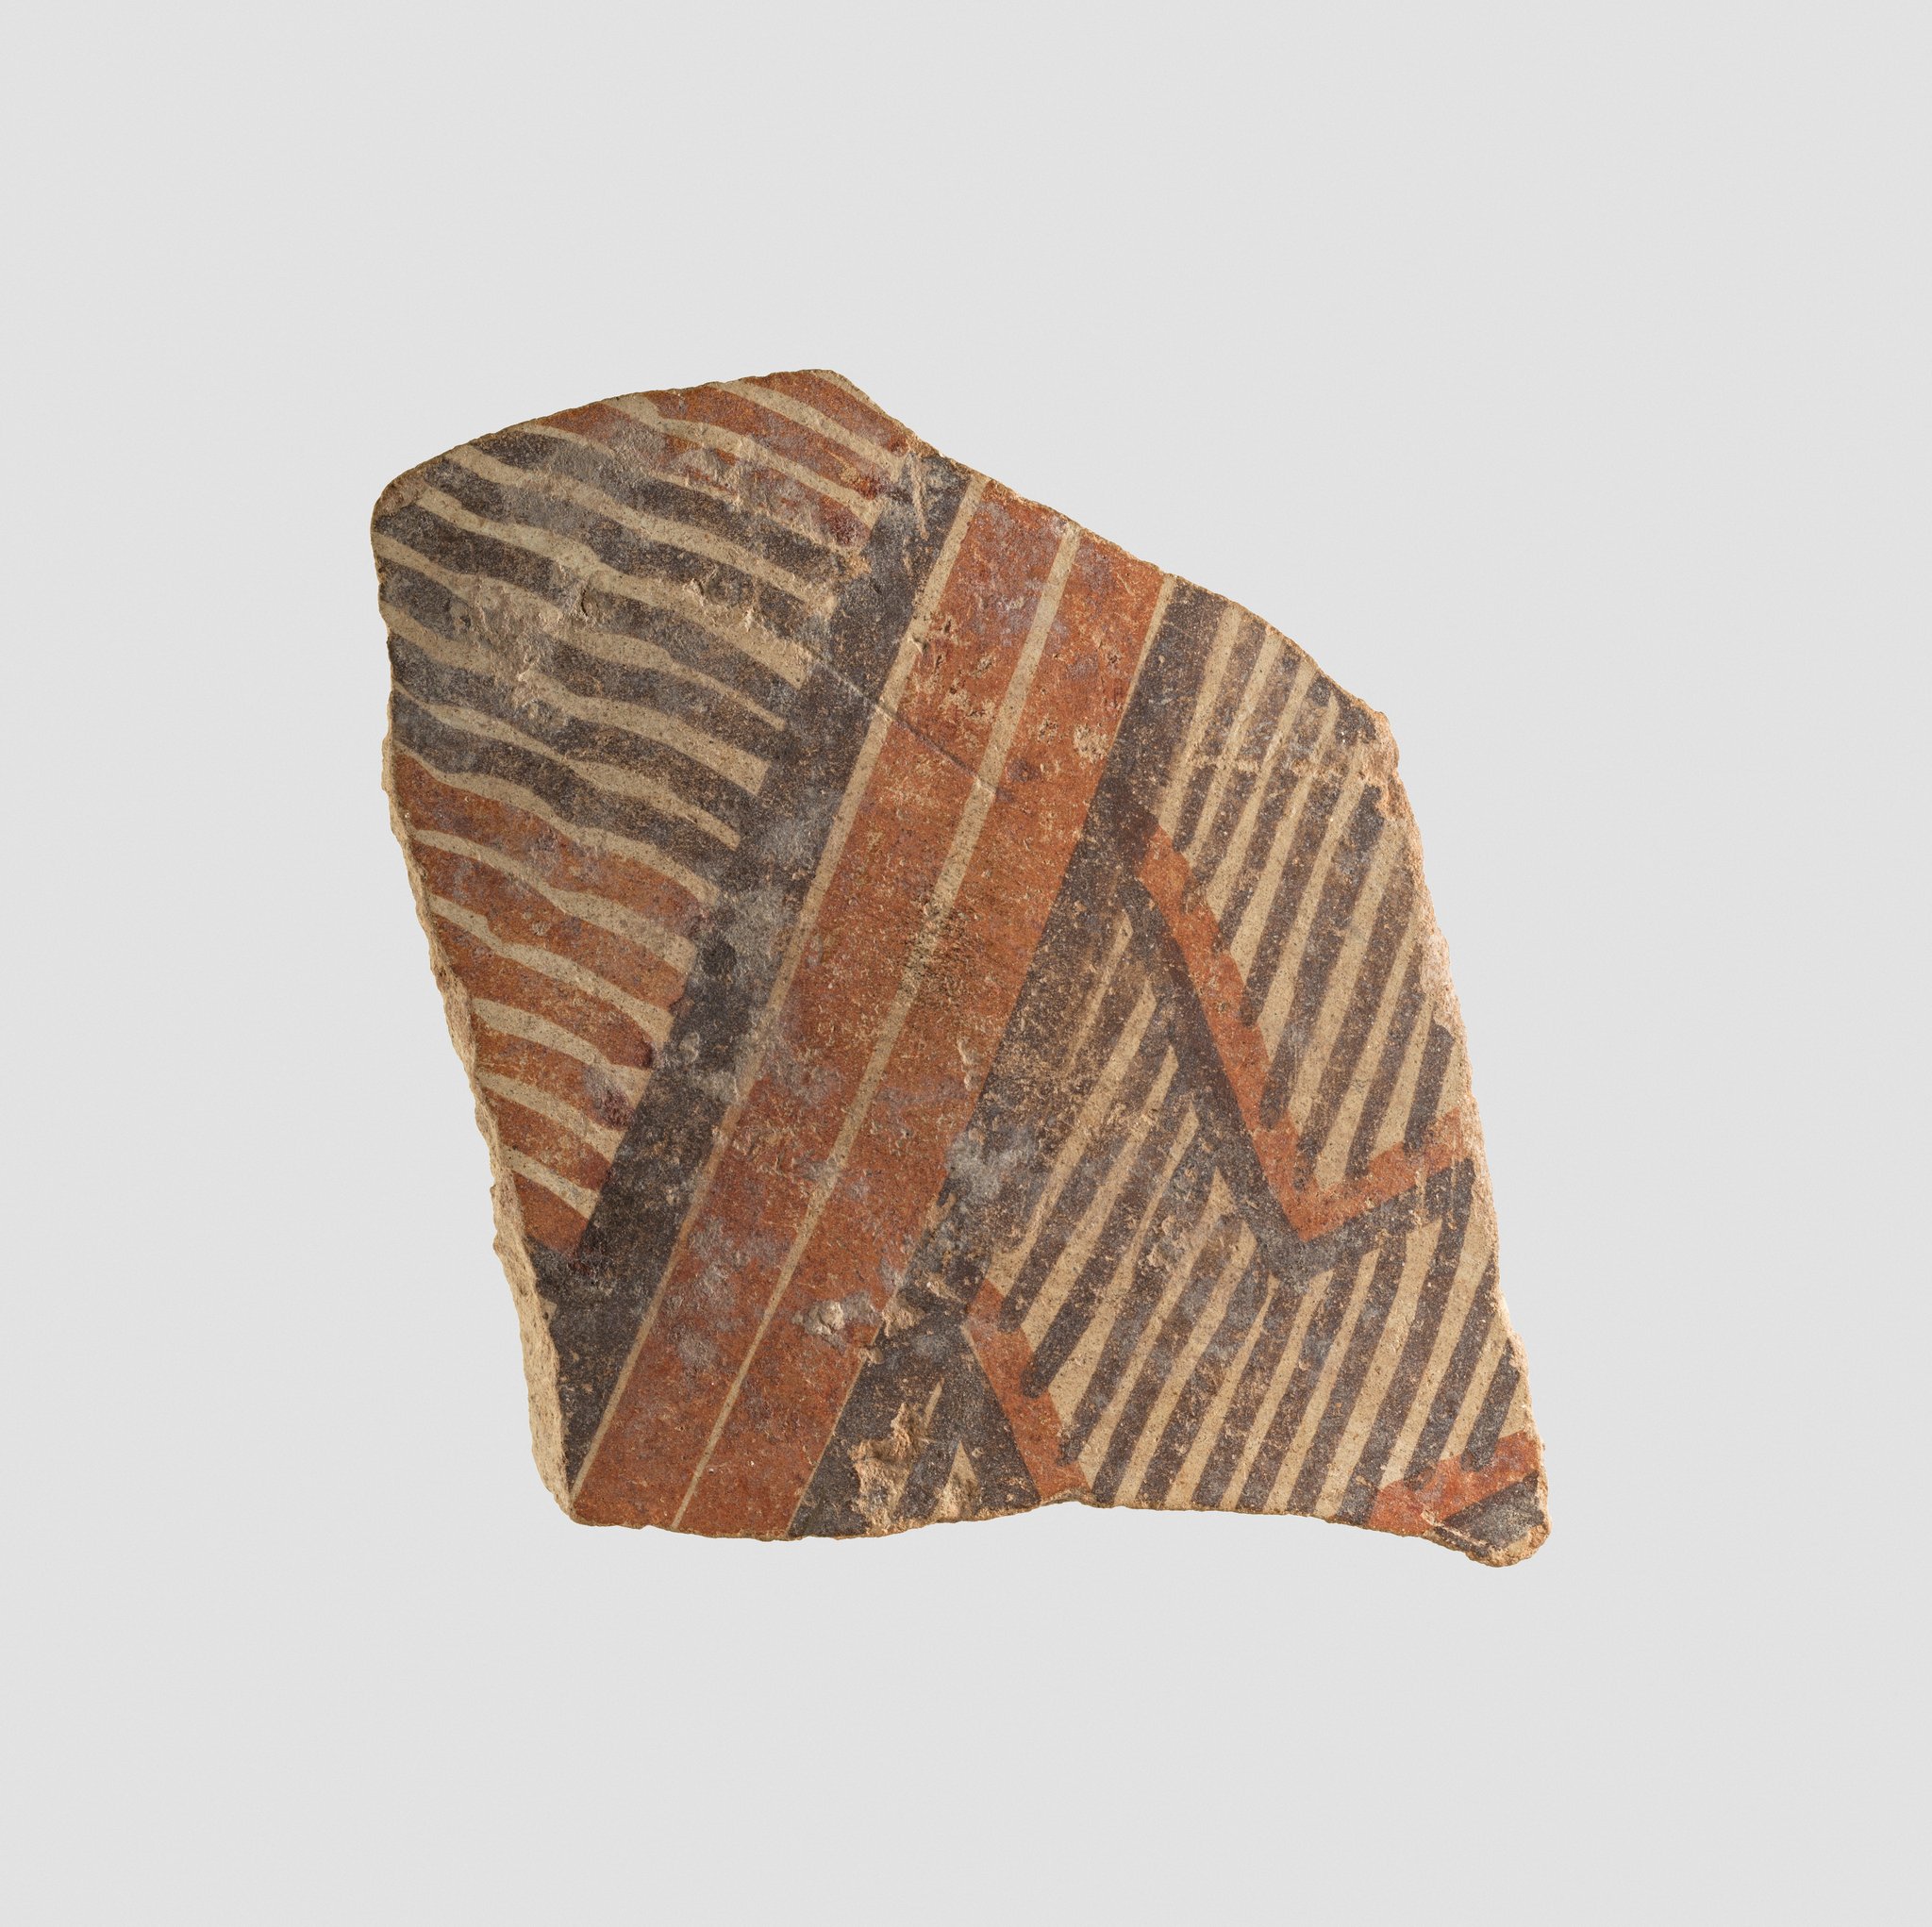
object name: sherd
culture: halaf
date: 5000-4500 BCE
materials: ceramic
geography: syria